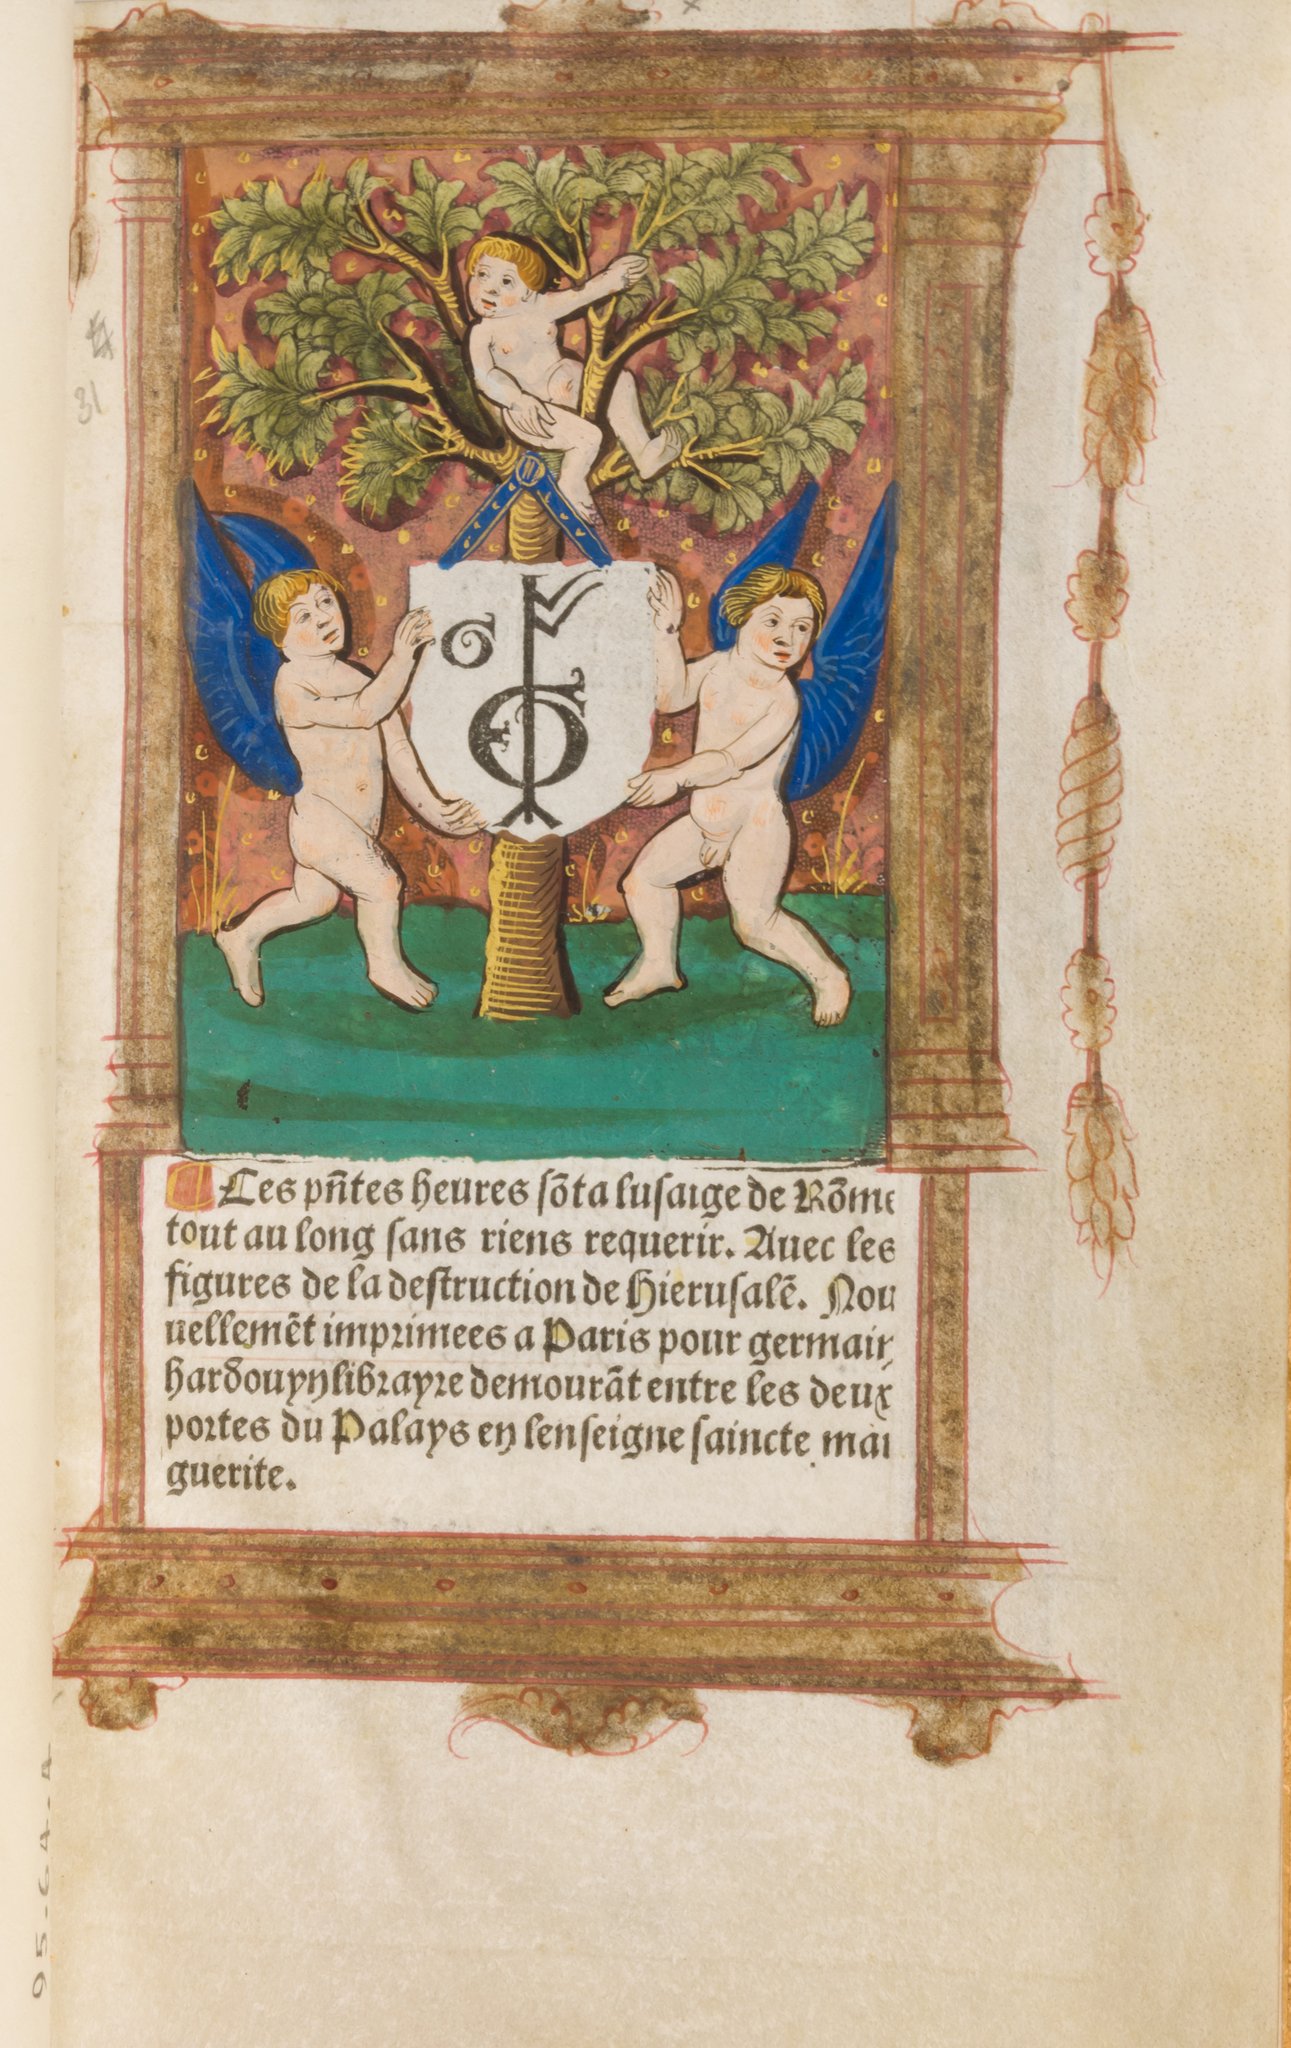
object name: book of hour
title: Book of Hours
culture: french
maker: gilles hardouyn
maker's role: publisher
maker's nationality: french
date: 1518-1521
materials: gold, ink, leather, parchment, paint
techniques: bookbinding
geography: france